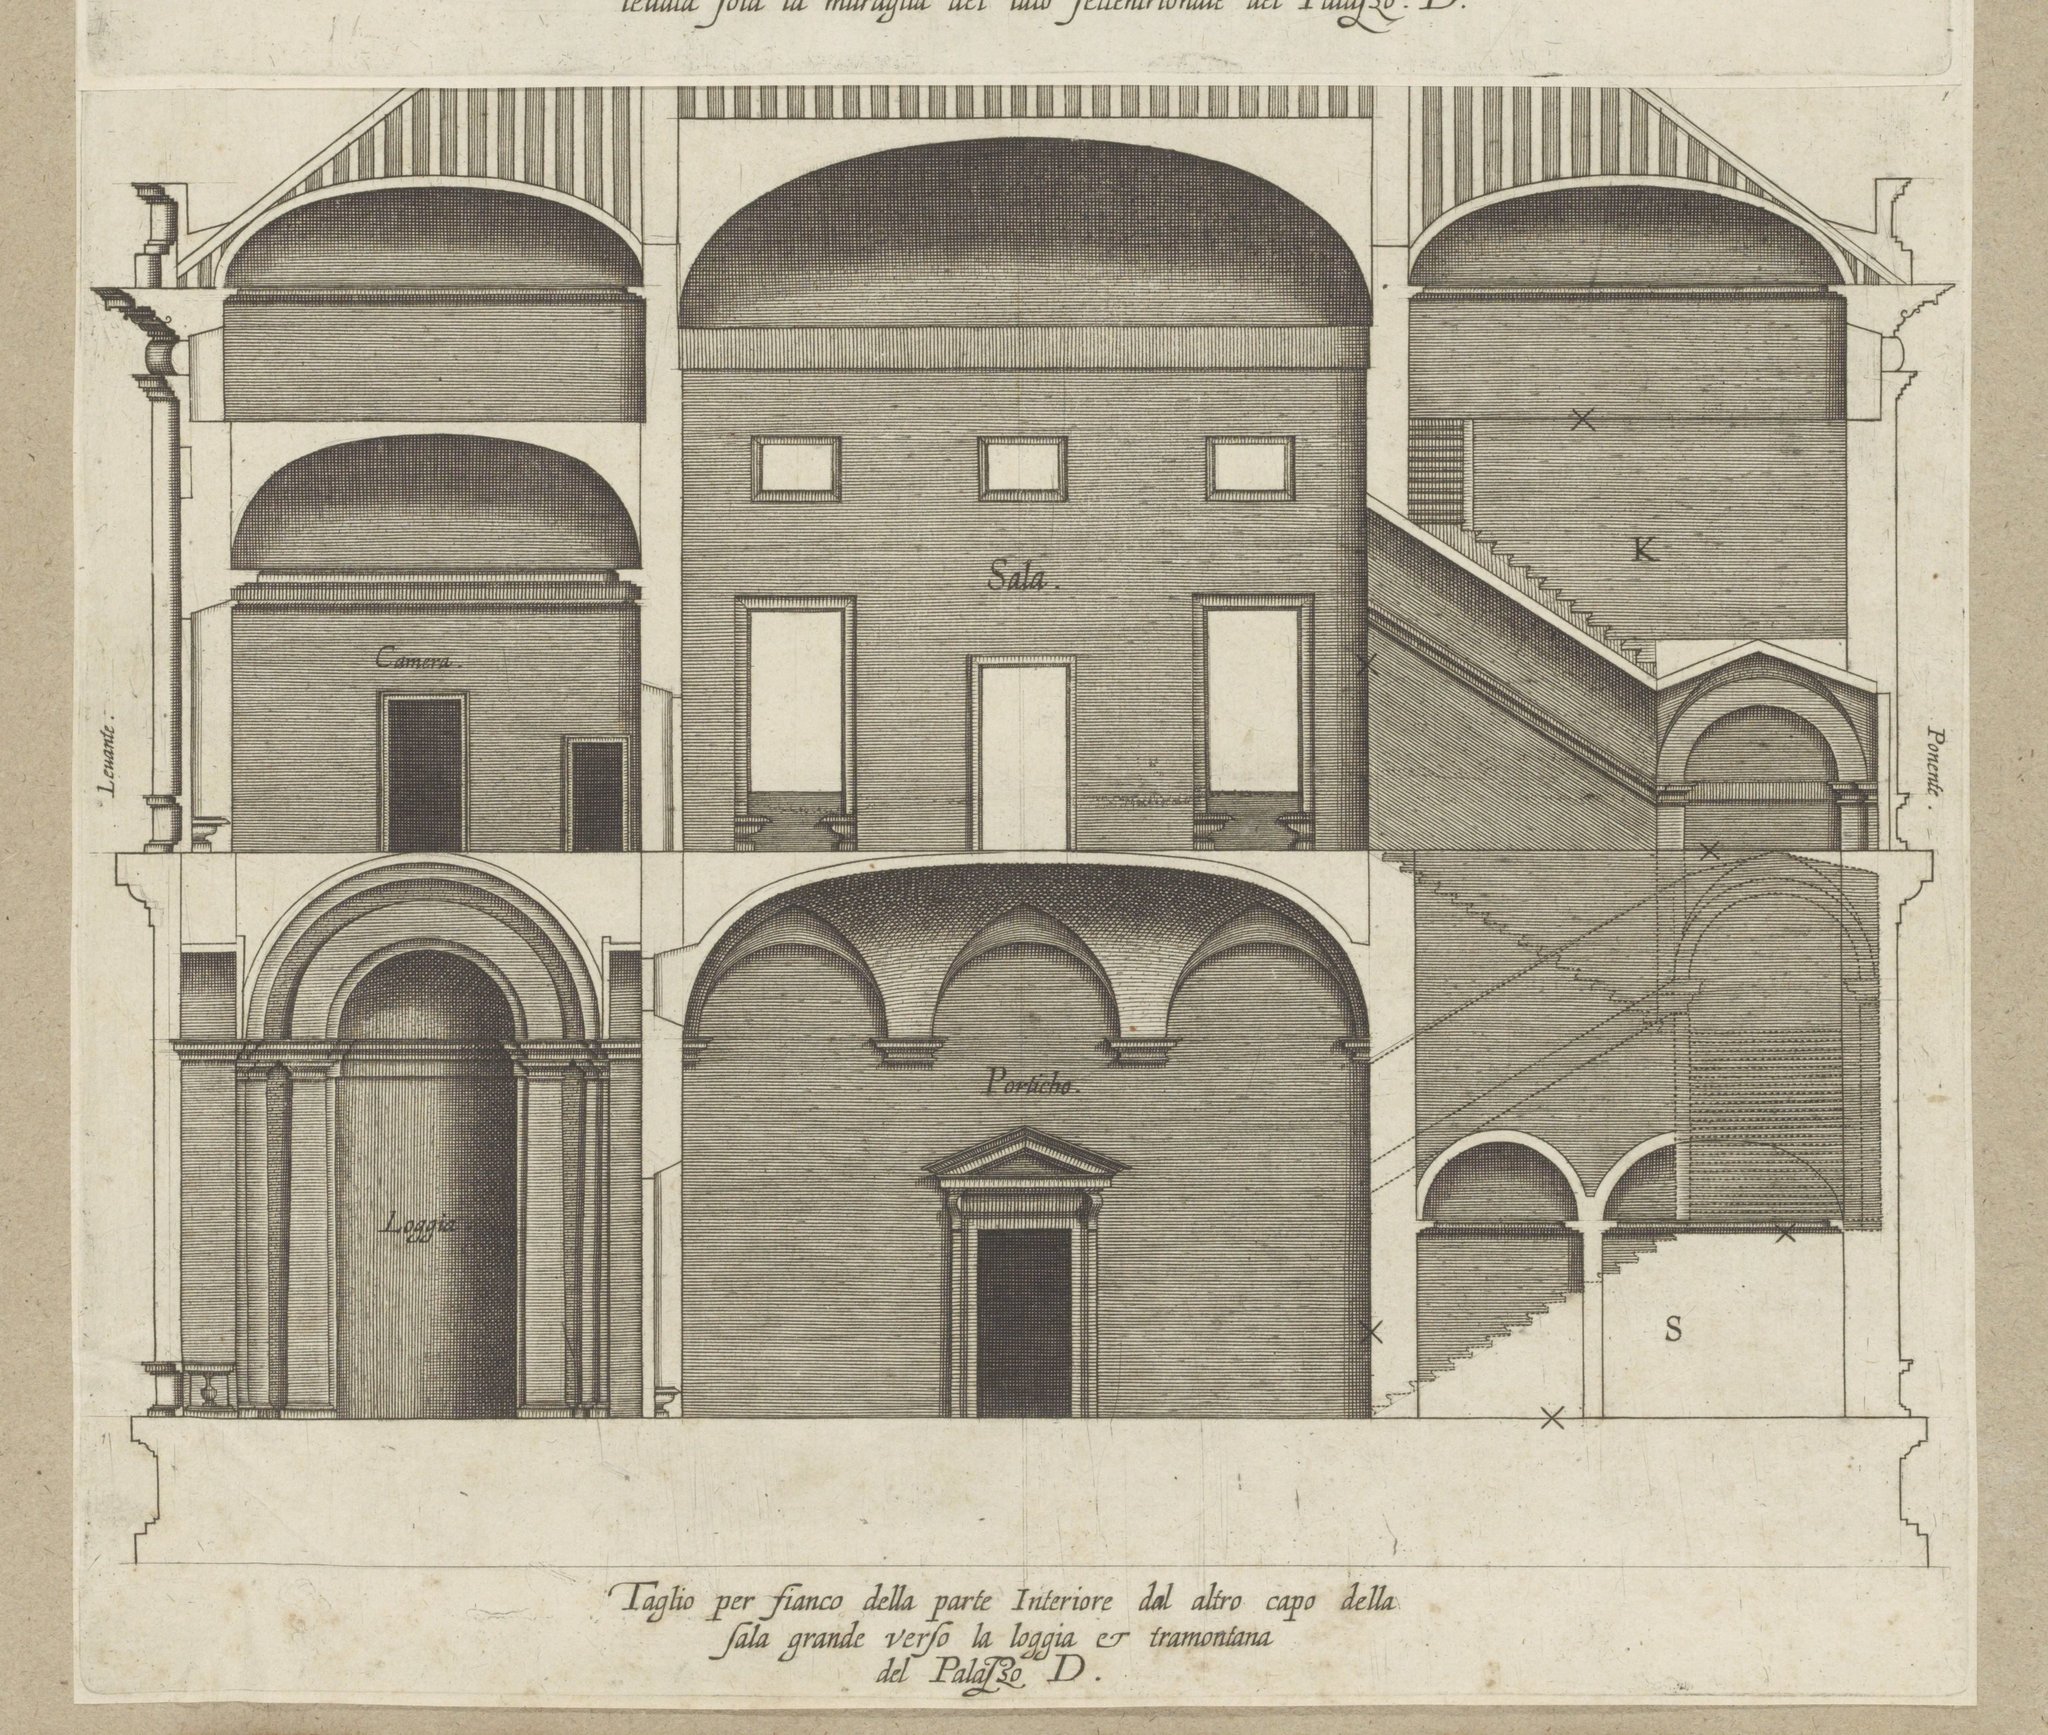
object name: album leaf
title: Langsdoorsnede van de villa Grimaldi te Genua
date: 1622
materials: paper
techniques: engraving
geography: antwerp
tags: hôtel, i.e. small palace in city - aa - civic architecture: inside, section ~ architectural design or model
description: Deze prent maakt deel uit van een album.